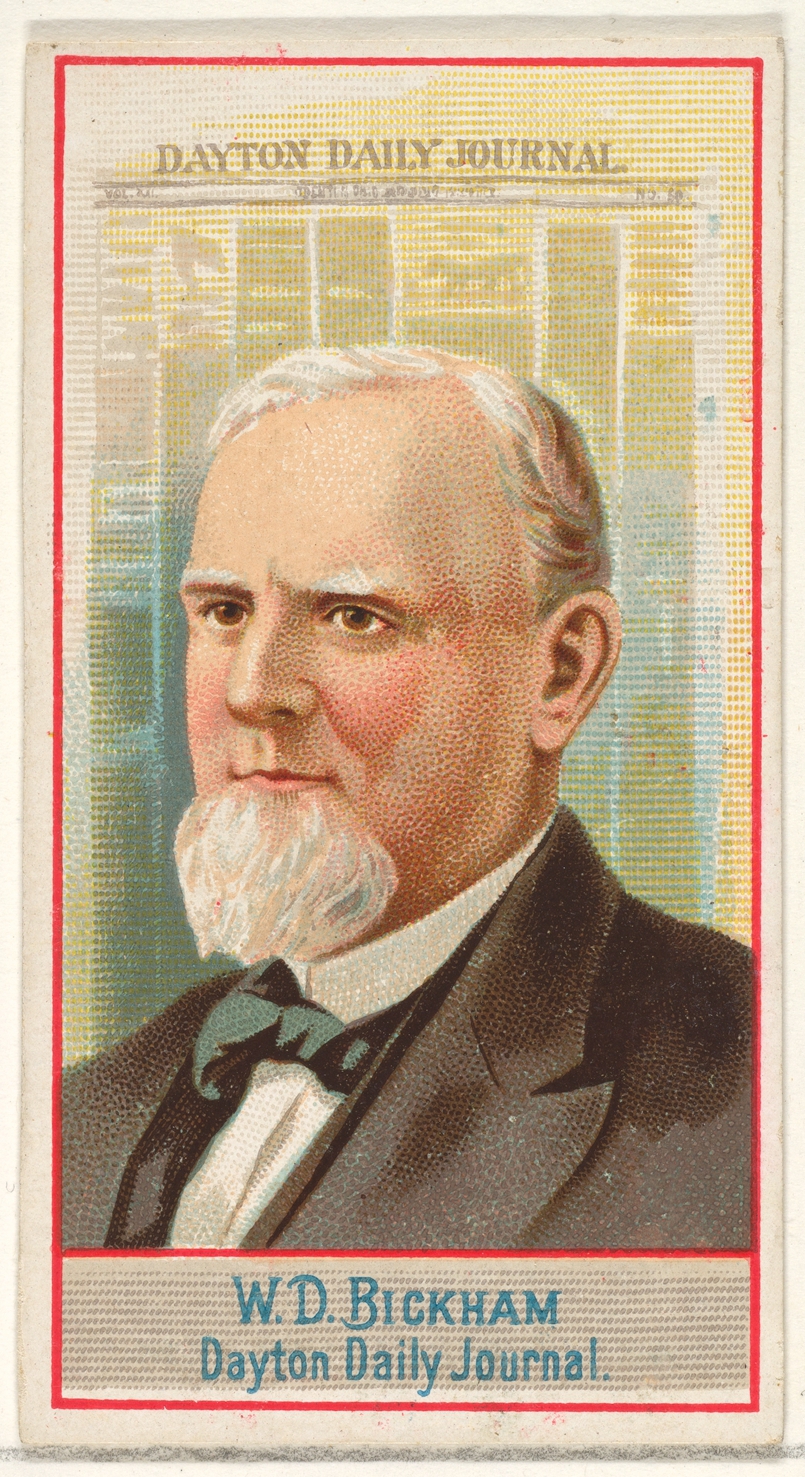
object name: print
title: W.D. Bickham, Dayton Daily Journal, from the American Editors series (N1) for Allen & Ginter Cigarettes Brands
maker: allen & ginter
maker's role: publisher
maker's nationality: american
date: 1887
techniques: color lithograph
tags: men,portraits